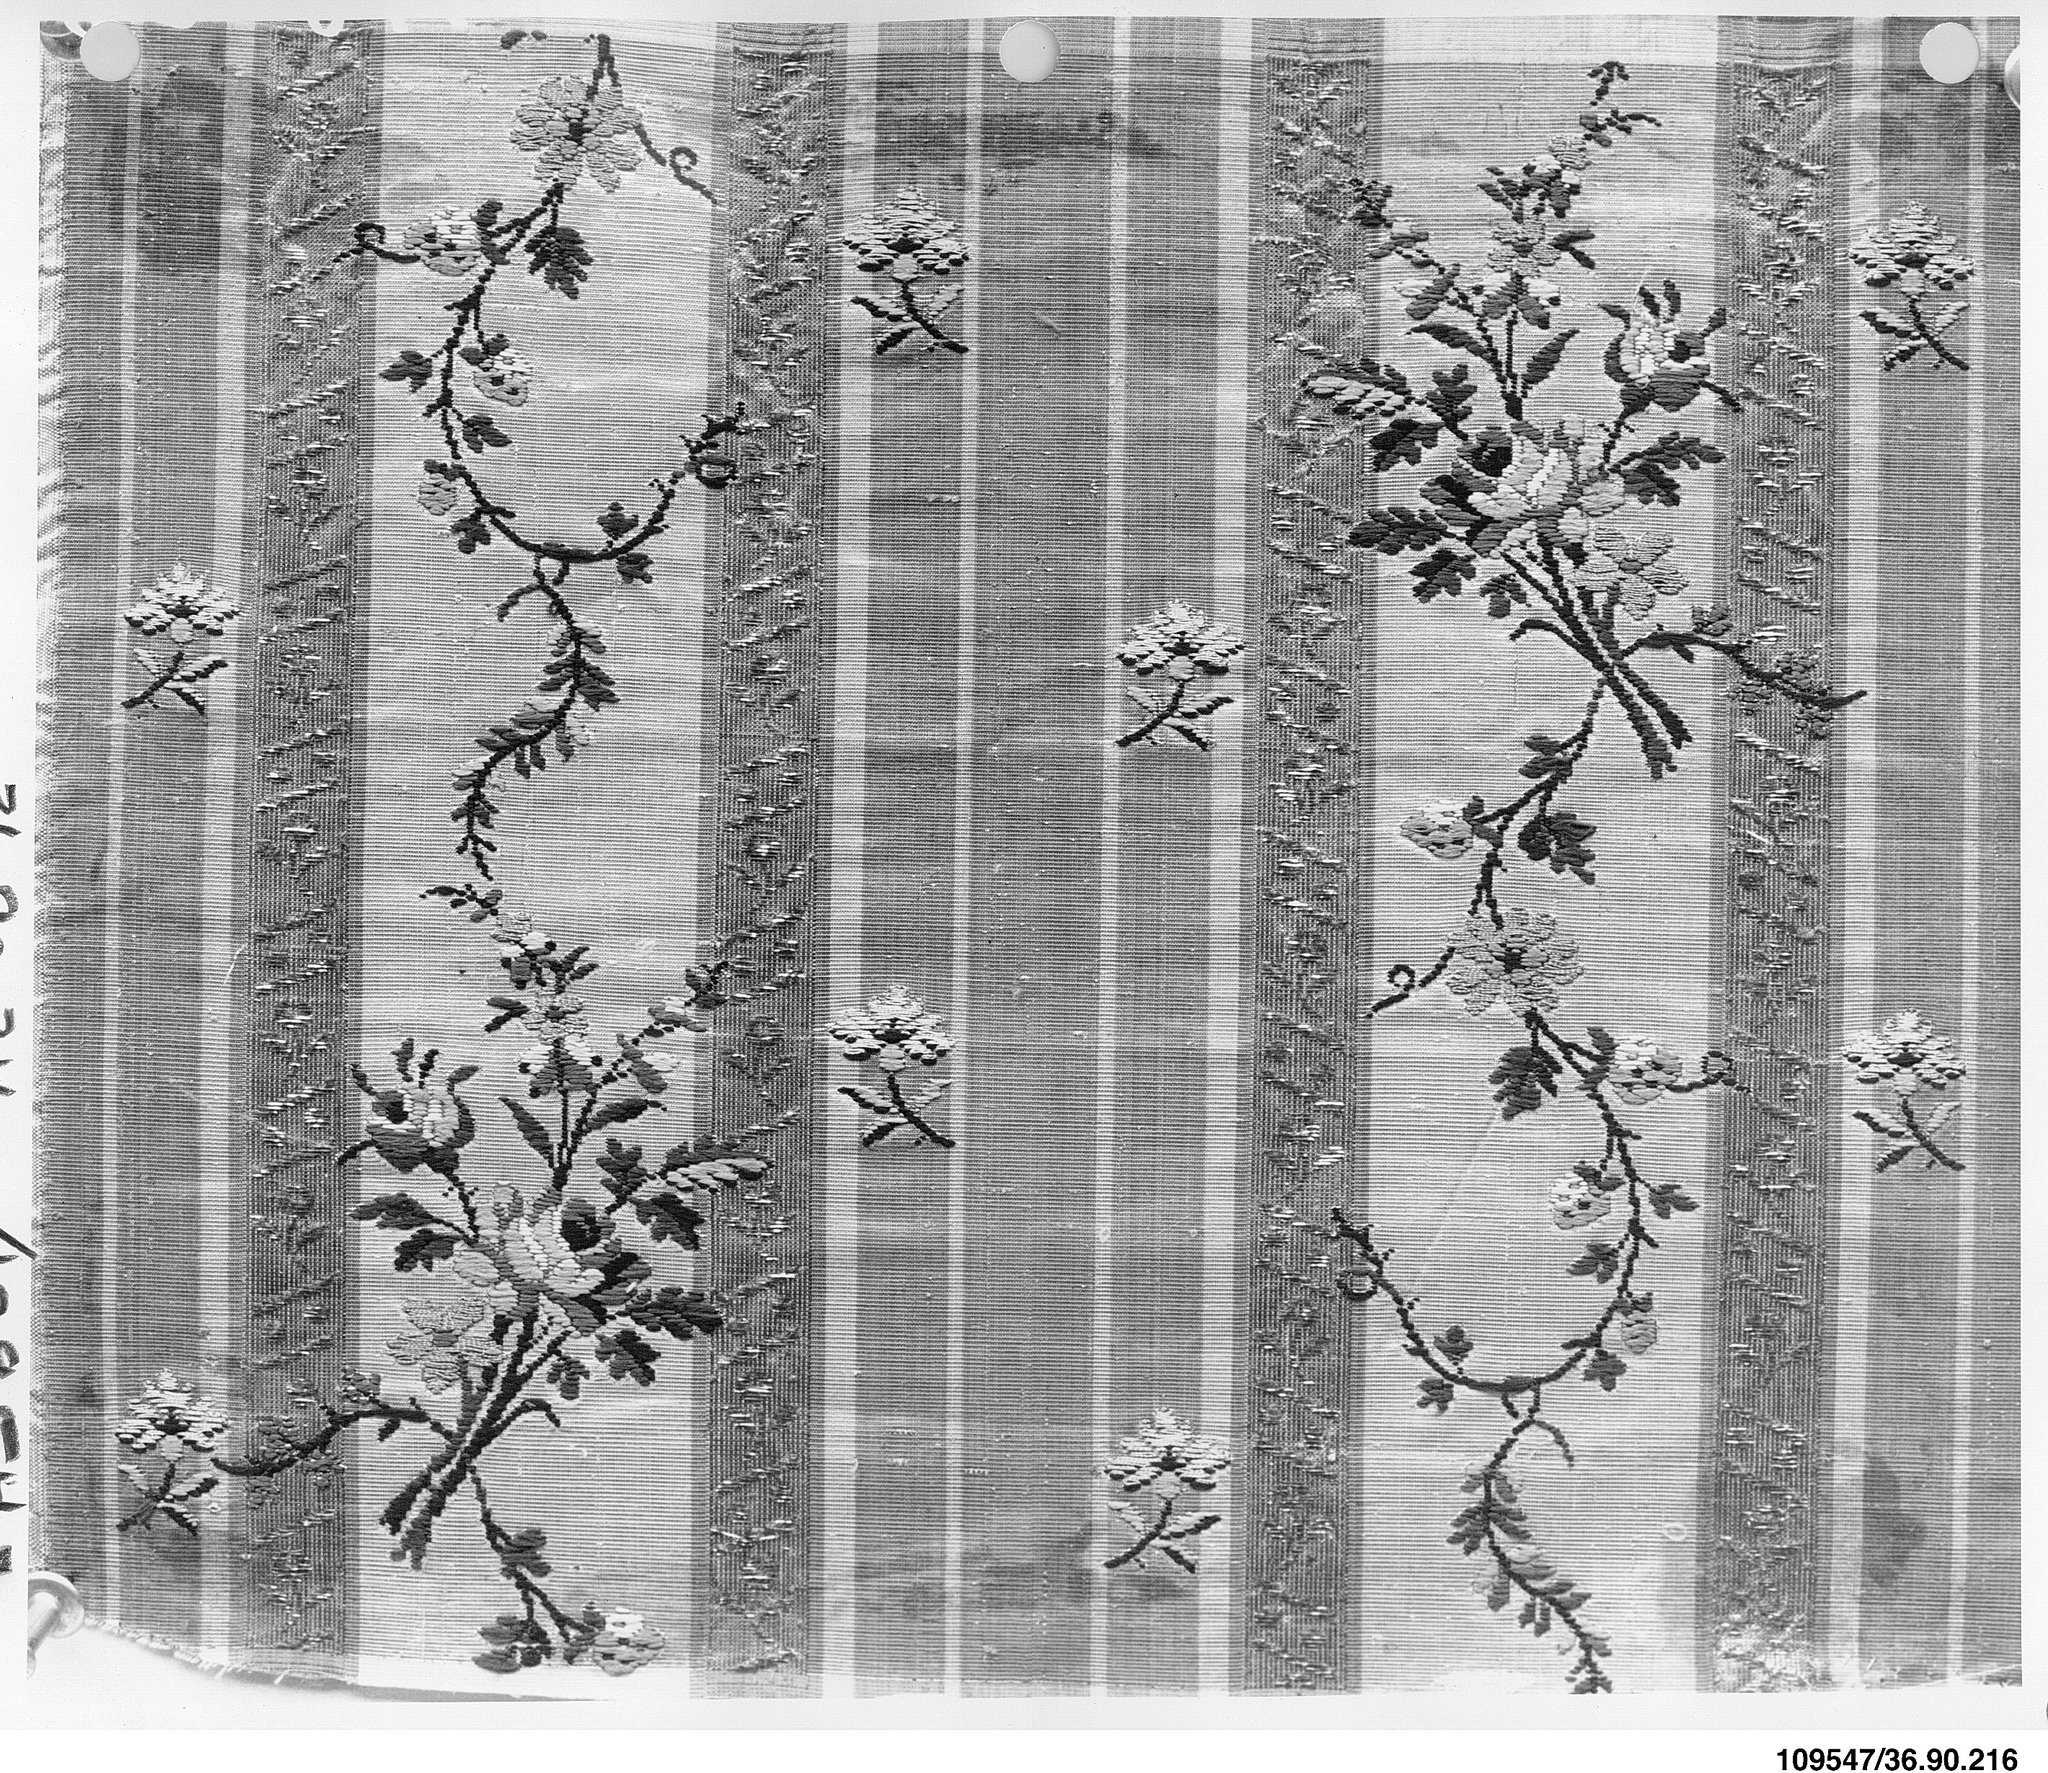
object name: piece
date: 1701-1800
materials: metal thread, silk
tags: flowers